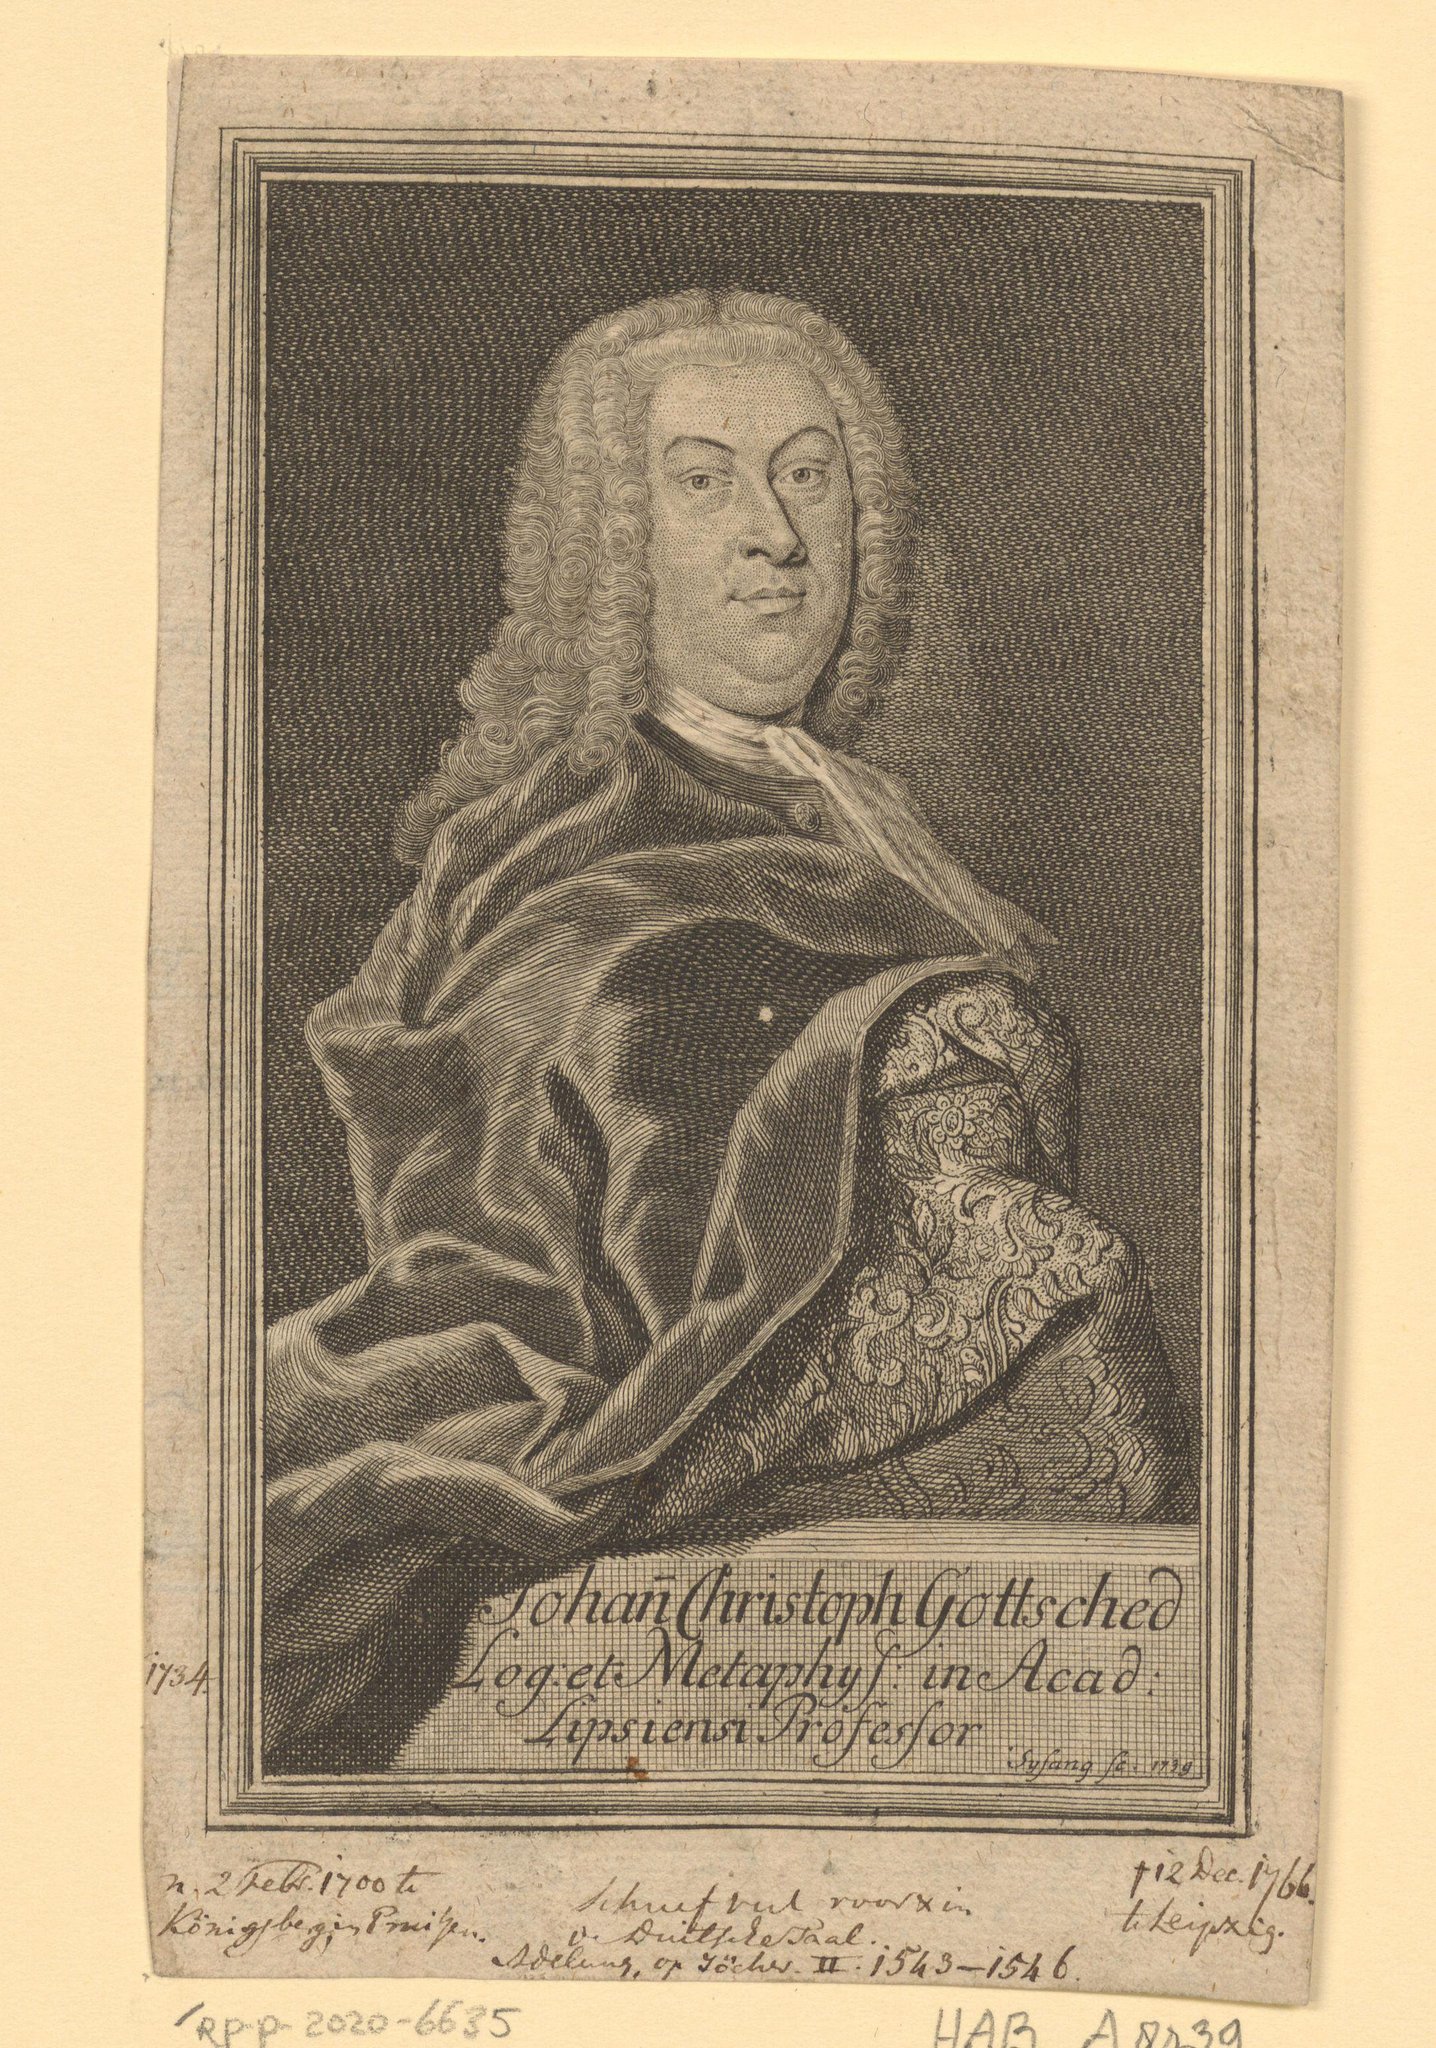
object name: print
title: Portret van Johann Christoph Gottsched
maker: johann christoph sysang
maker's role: print maker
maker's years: 1703-1757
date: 1739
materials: paper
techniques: engraving, etching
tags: historical persons, writer, poet, author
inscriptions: tekst, recto, handgeschreven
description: Prent waarschijnlijk uit: Deutsche Acta Eruditorum (...). Leipzig: Johann Friedrich Gleditsch, 1739.